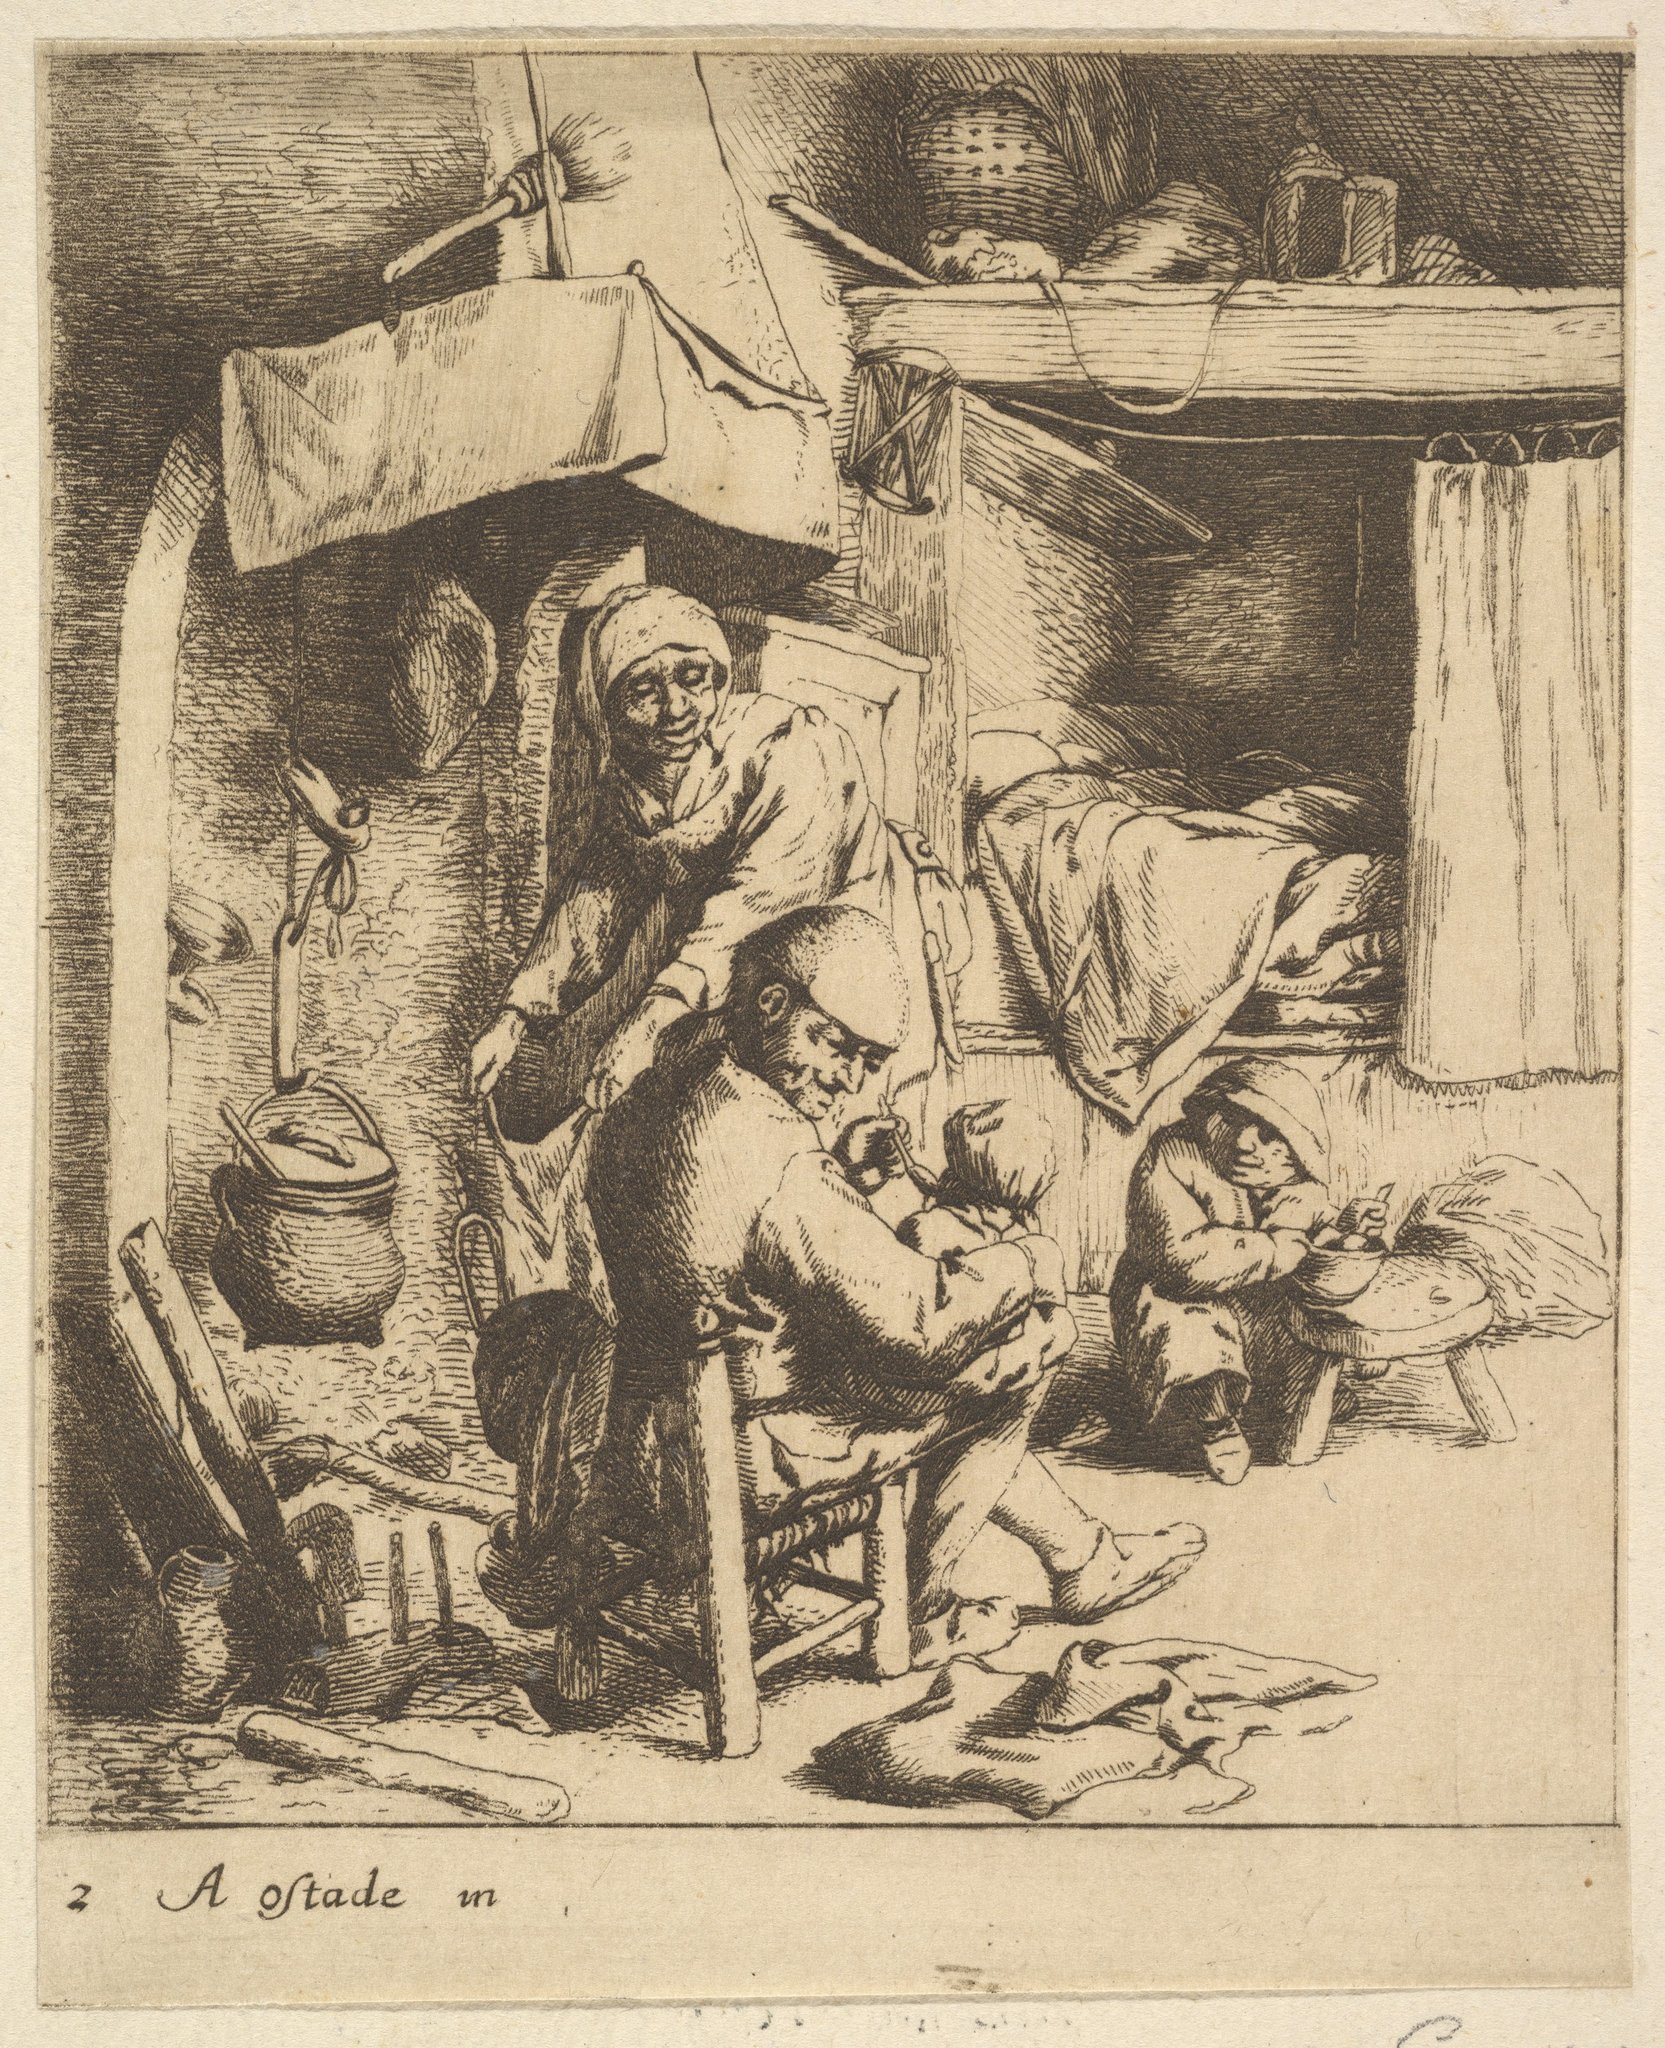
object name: print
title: Father Feeding Child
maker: adriaen van ostade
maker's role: artist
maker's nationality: dutch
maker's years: 1610-1685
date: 1610-1685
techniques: etching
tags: interiors,kitchens,infants,fathers,women,beds,eating